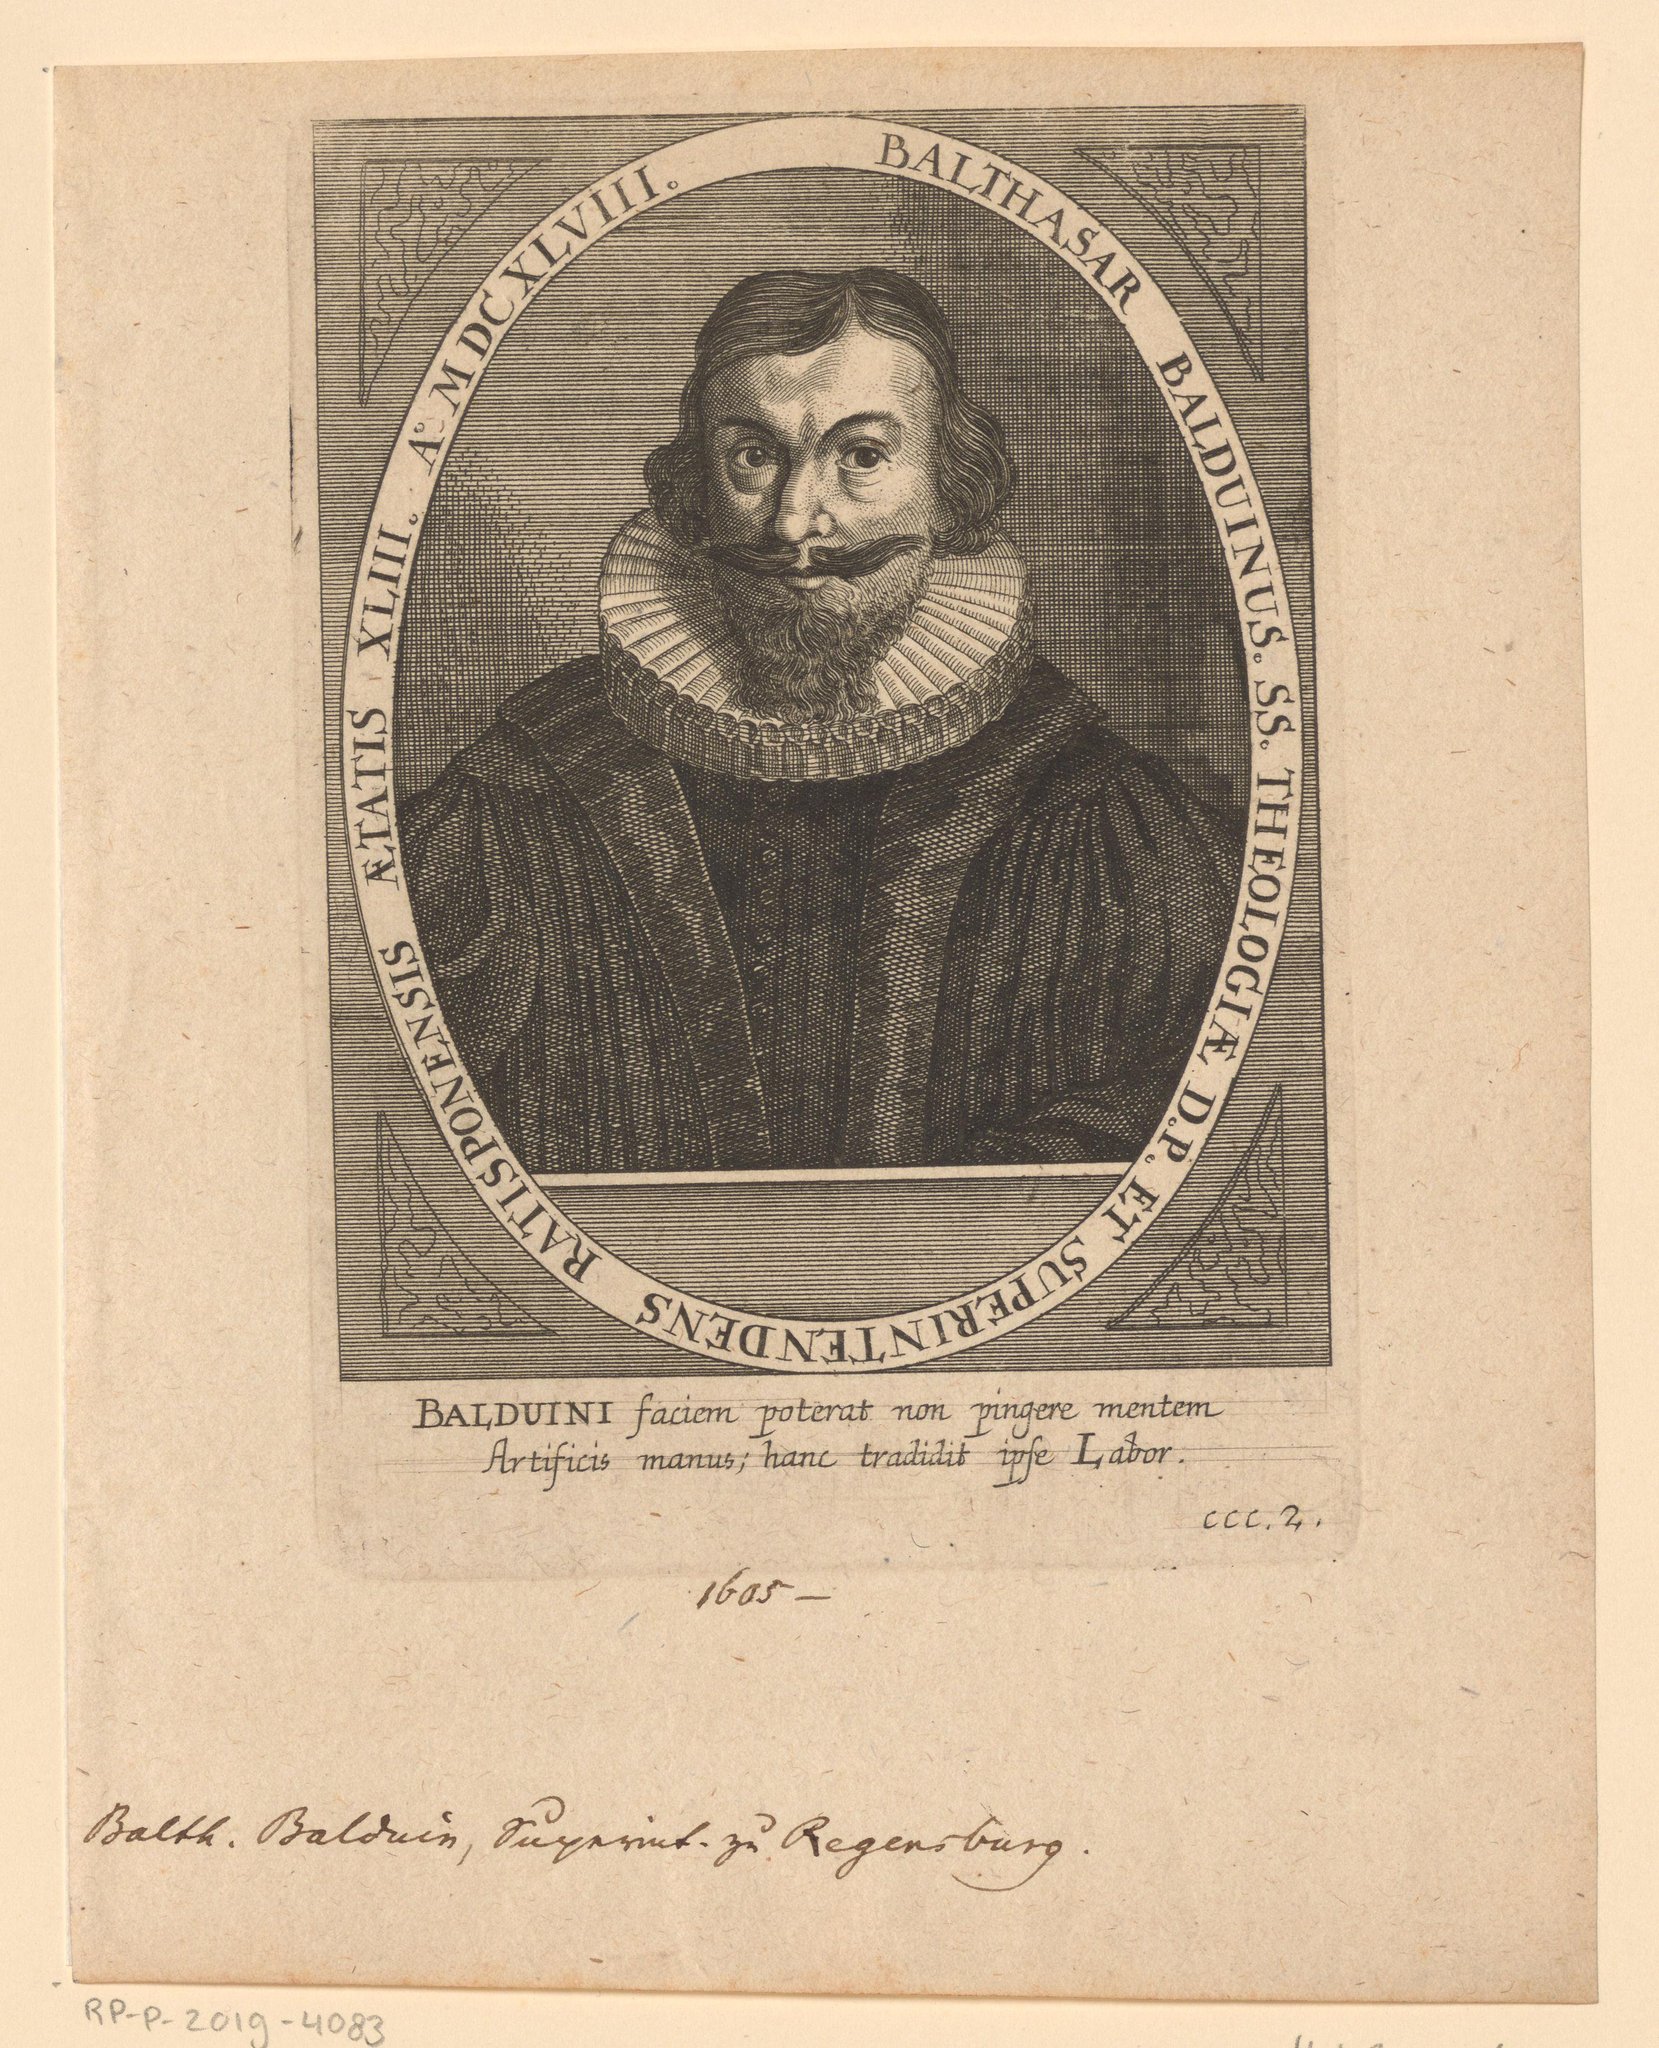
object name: print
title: Portret van Balthasar Balduin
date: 1652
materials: paper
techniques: engraving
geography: frankfurt am main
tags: theologian, historical persons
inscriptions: inscription: ‘1605 - Balth. Balduin, [...] Regensburg’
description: Prent uit: Boissard, Jean Jacques. Bibliotheca chalcographica. Frankfurt am Main: Johannes Ammon, 1652, dl. 8.